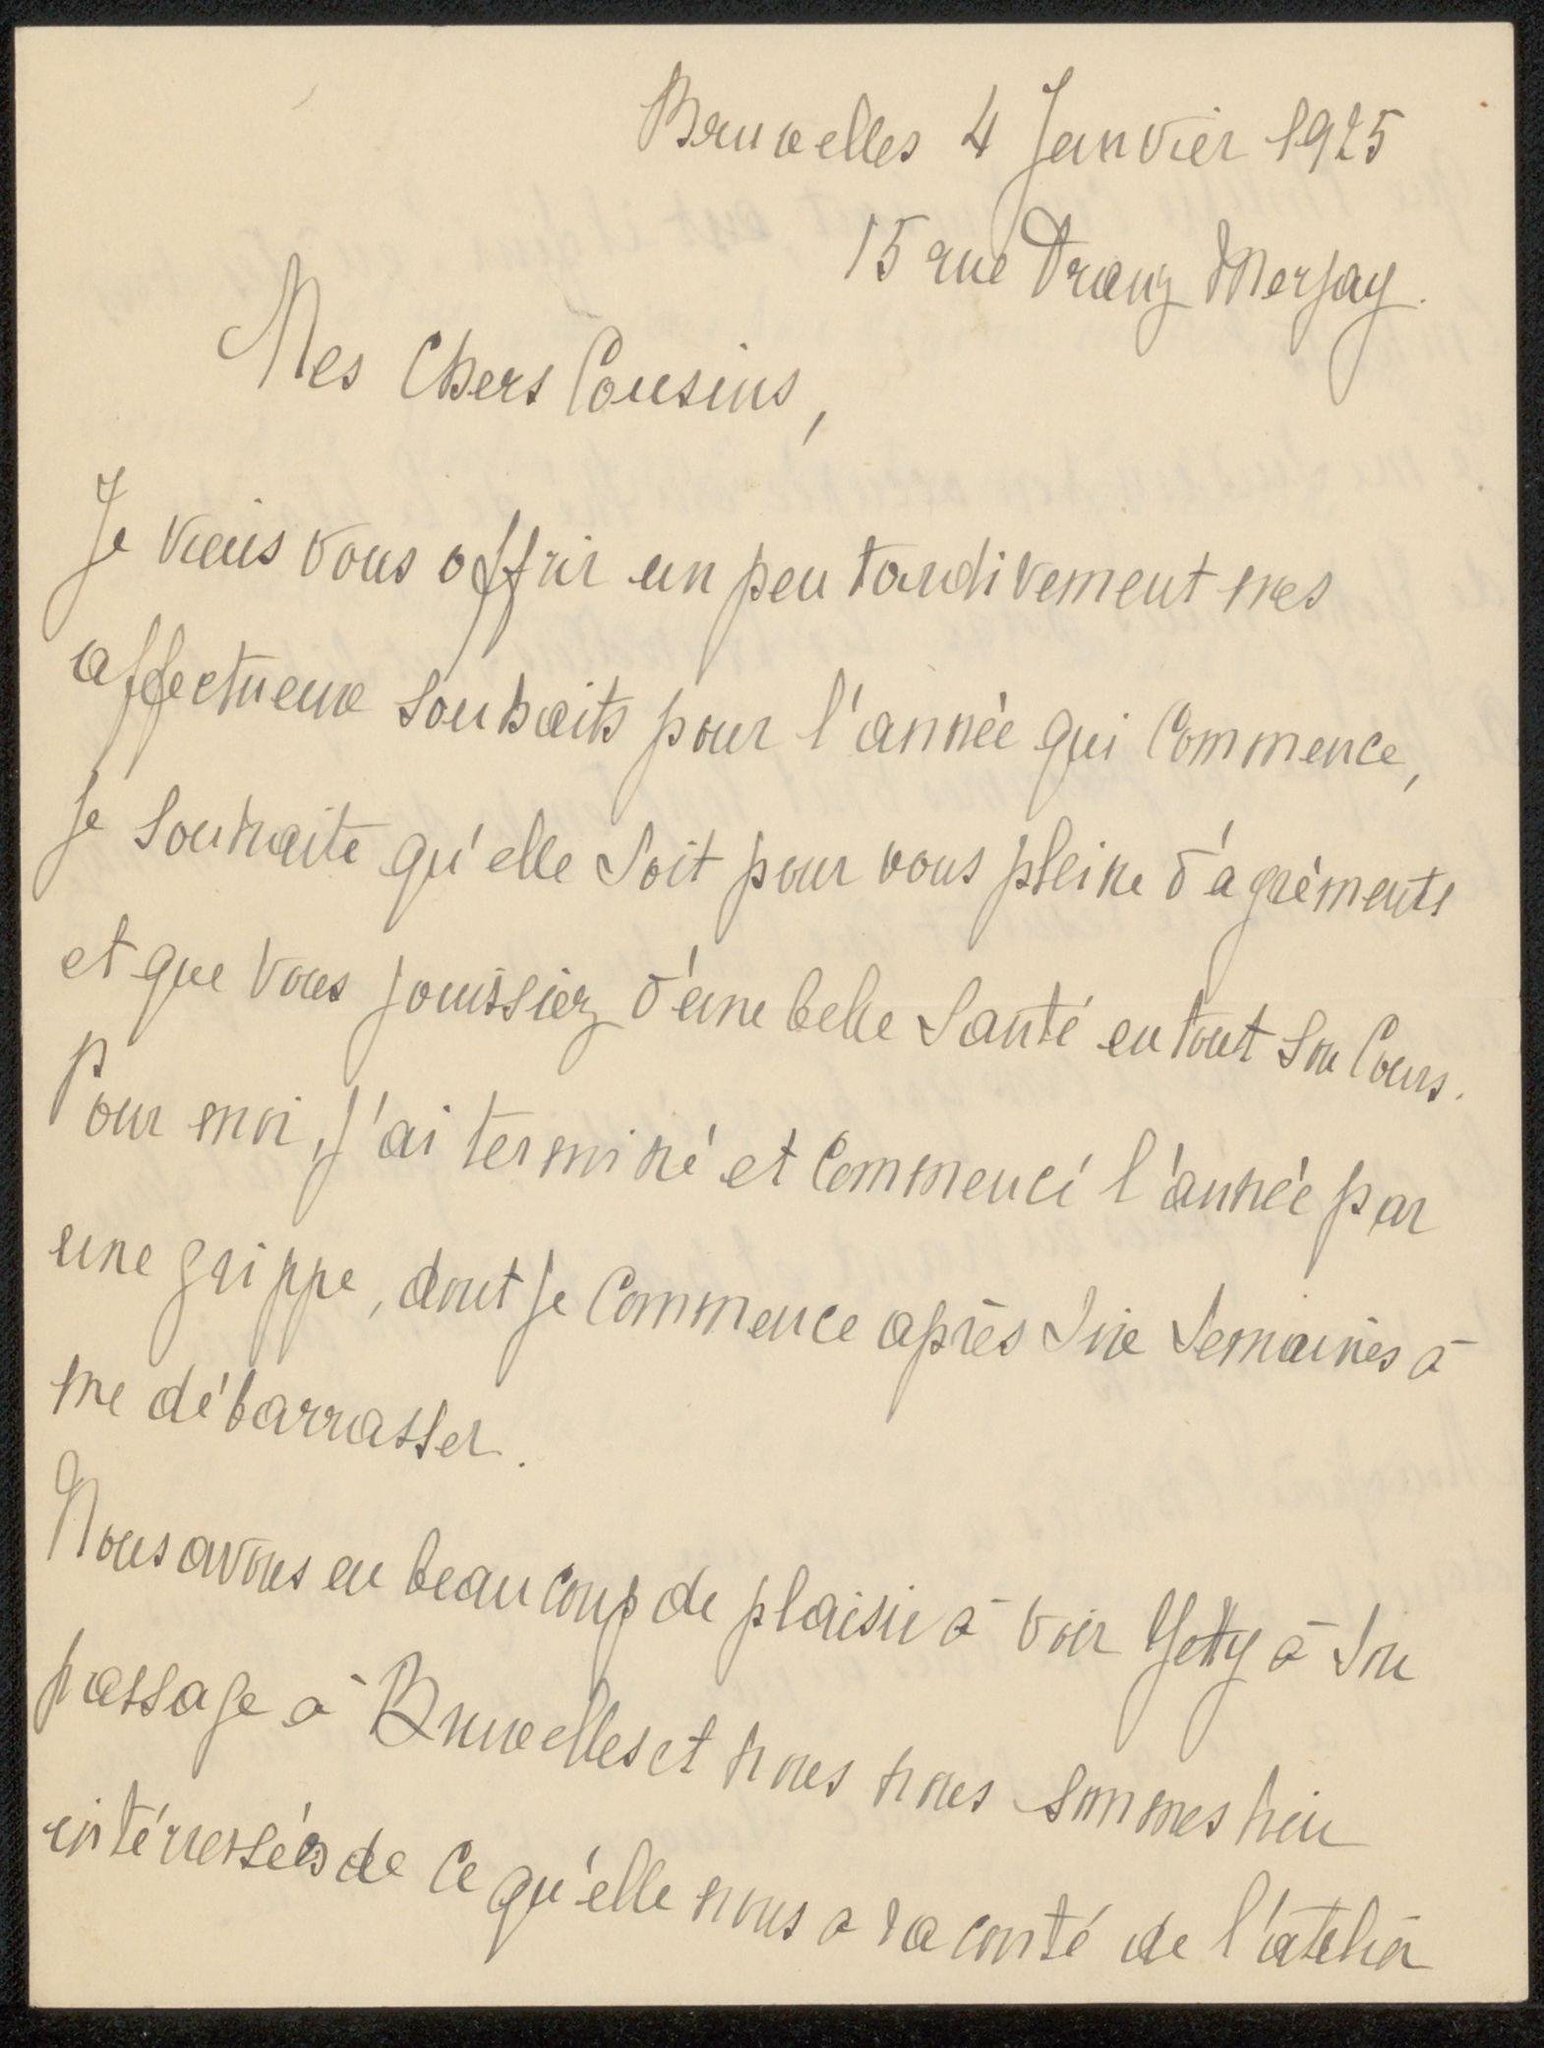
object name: letter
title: Brief aan Philip Zilcken en Henriette Wilhelmina van Baak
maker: marguerite stevens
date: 1925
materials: ink, paper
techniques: pen, writing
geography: brussels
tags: henriette wilhelmina van baak, draughtsman, philip zilcken, workshop, studio of the artist (in general), diseases, brussels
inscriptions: collector's mark: ‘RPK’